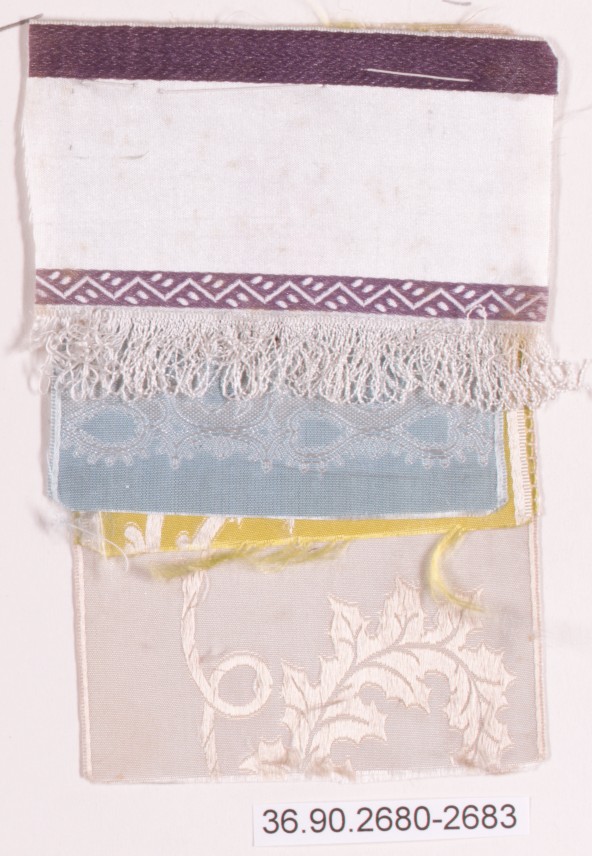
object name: ribbon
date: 1801-1900